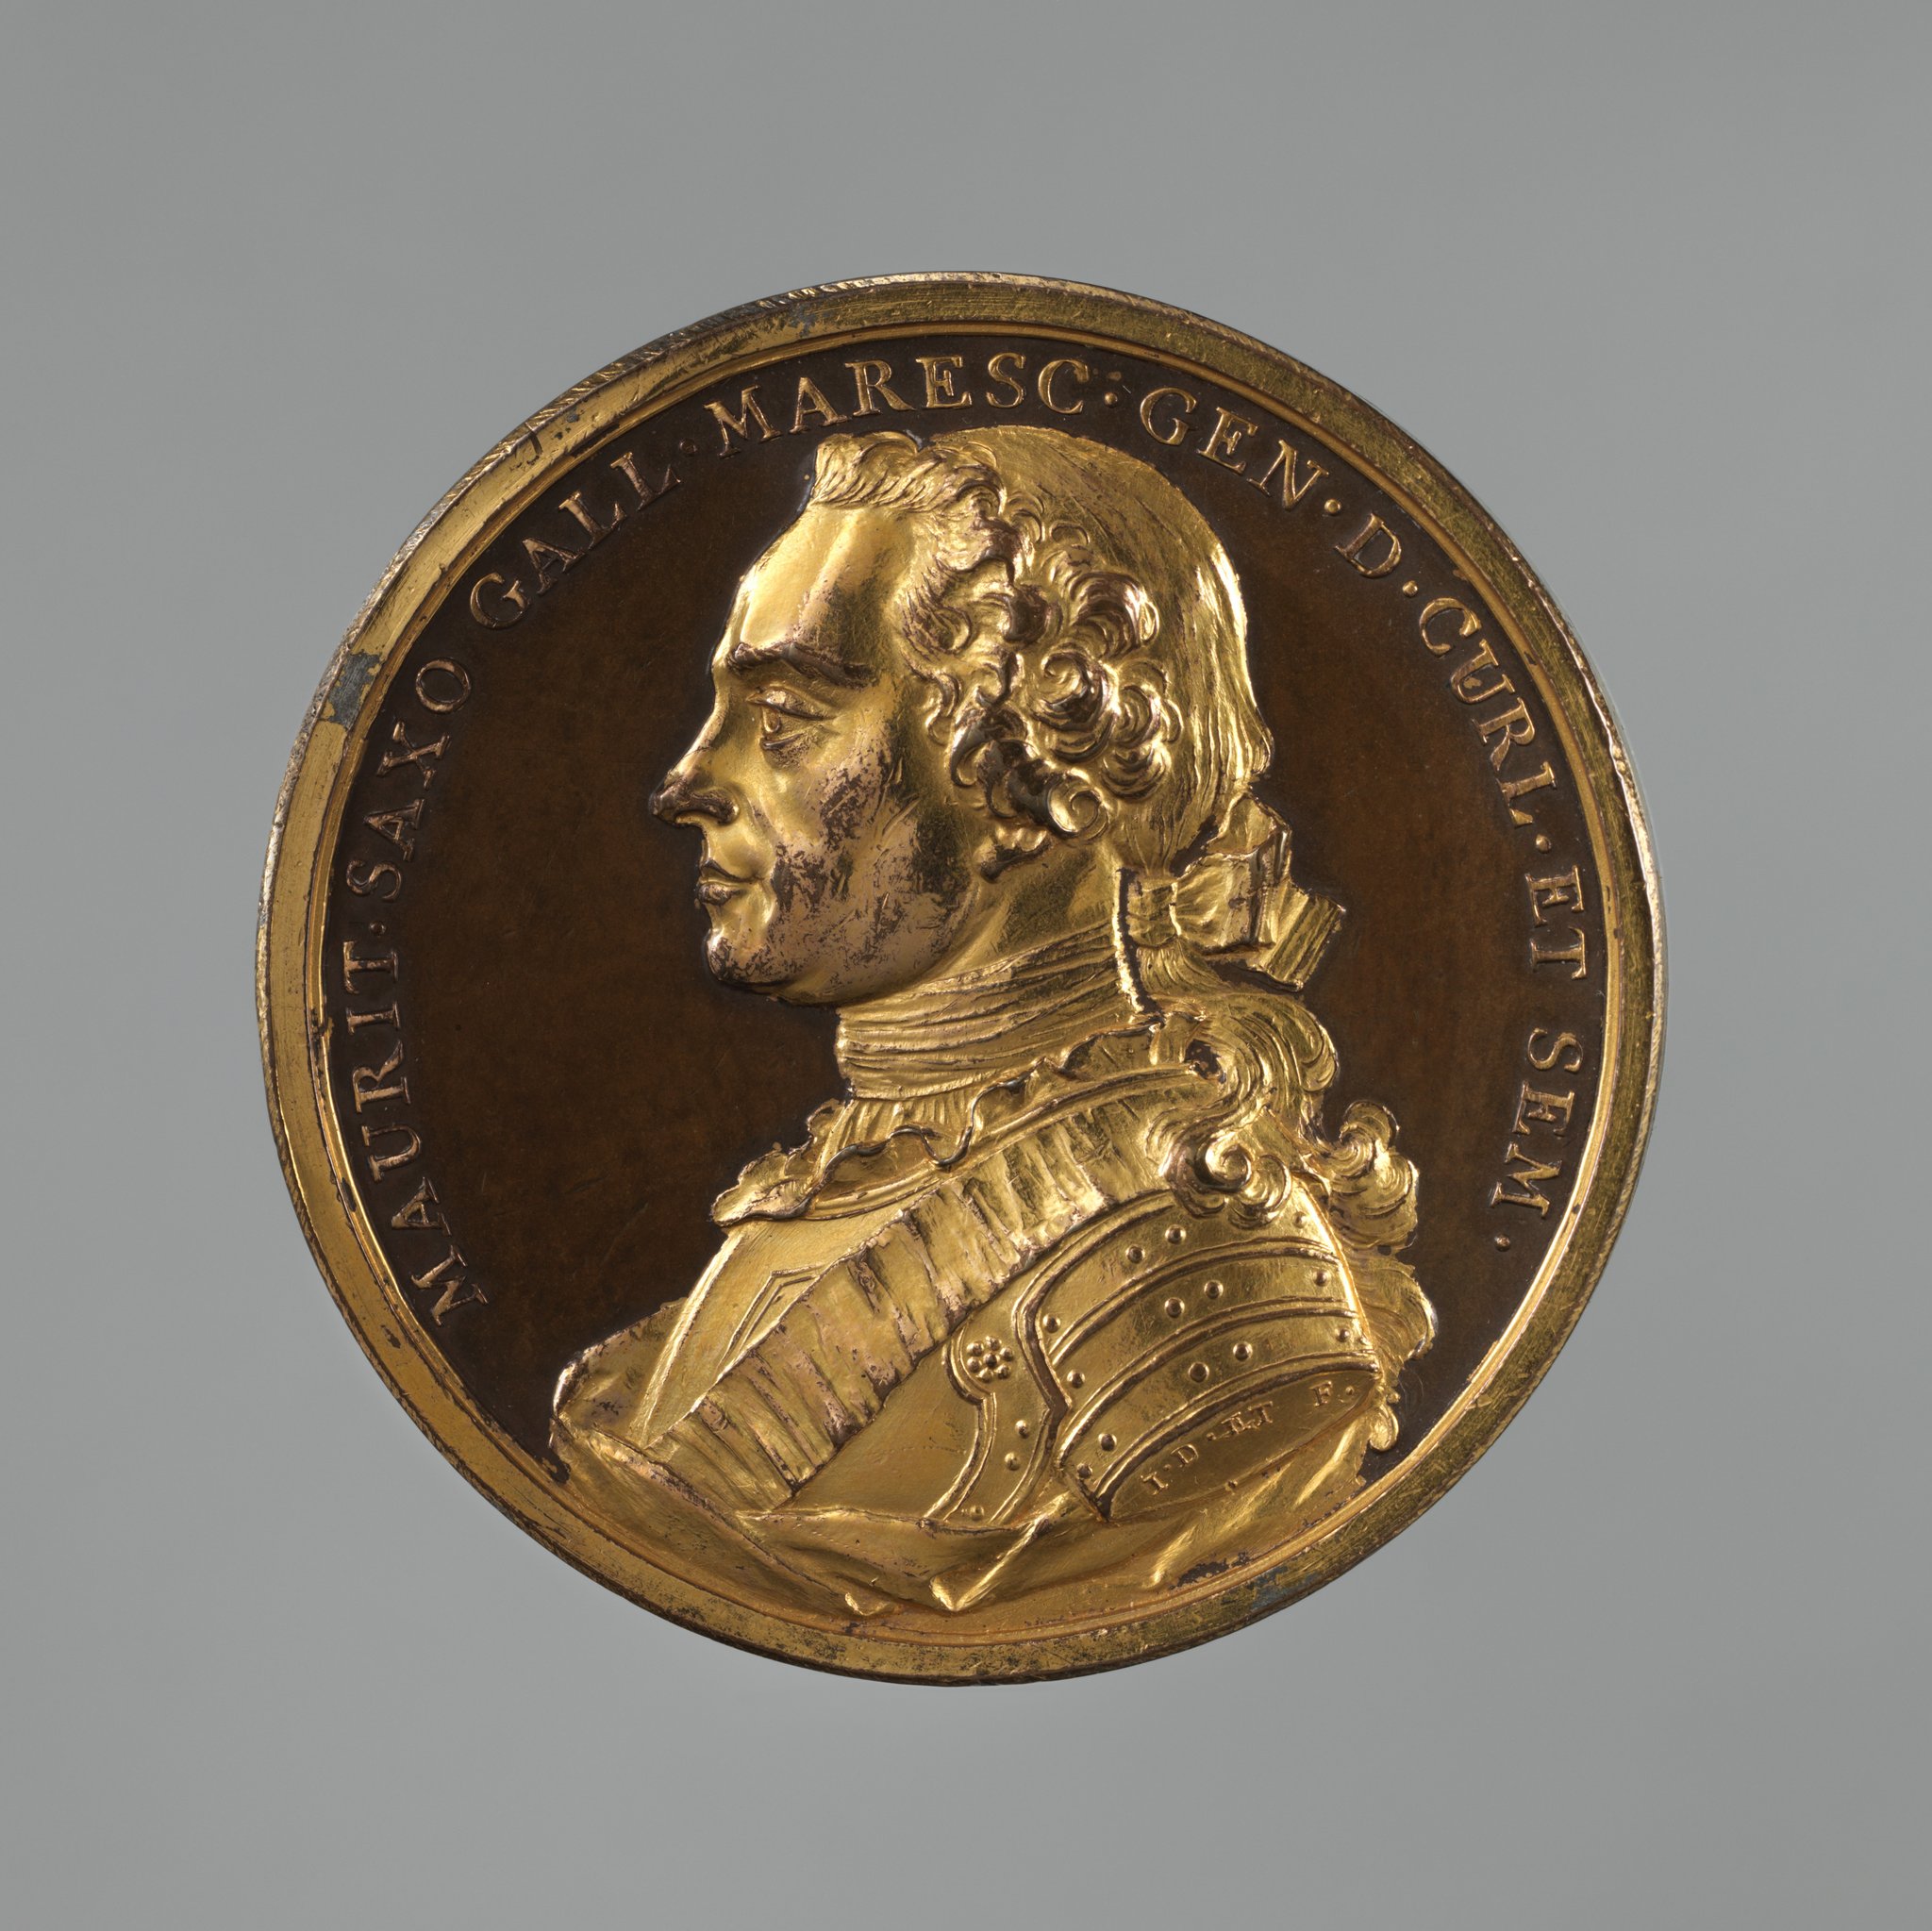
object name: medal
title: Victories of Maurice de Saxe, Marshal General of France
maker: jean dassier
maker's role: artist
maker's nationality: swiss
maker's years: 1676-1763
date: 1747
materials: gilt bronze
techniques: lacquer